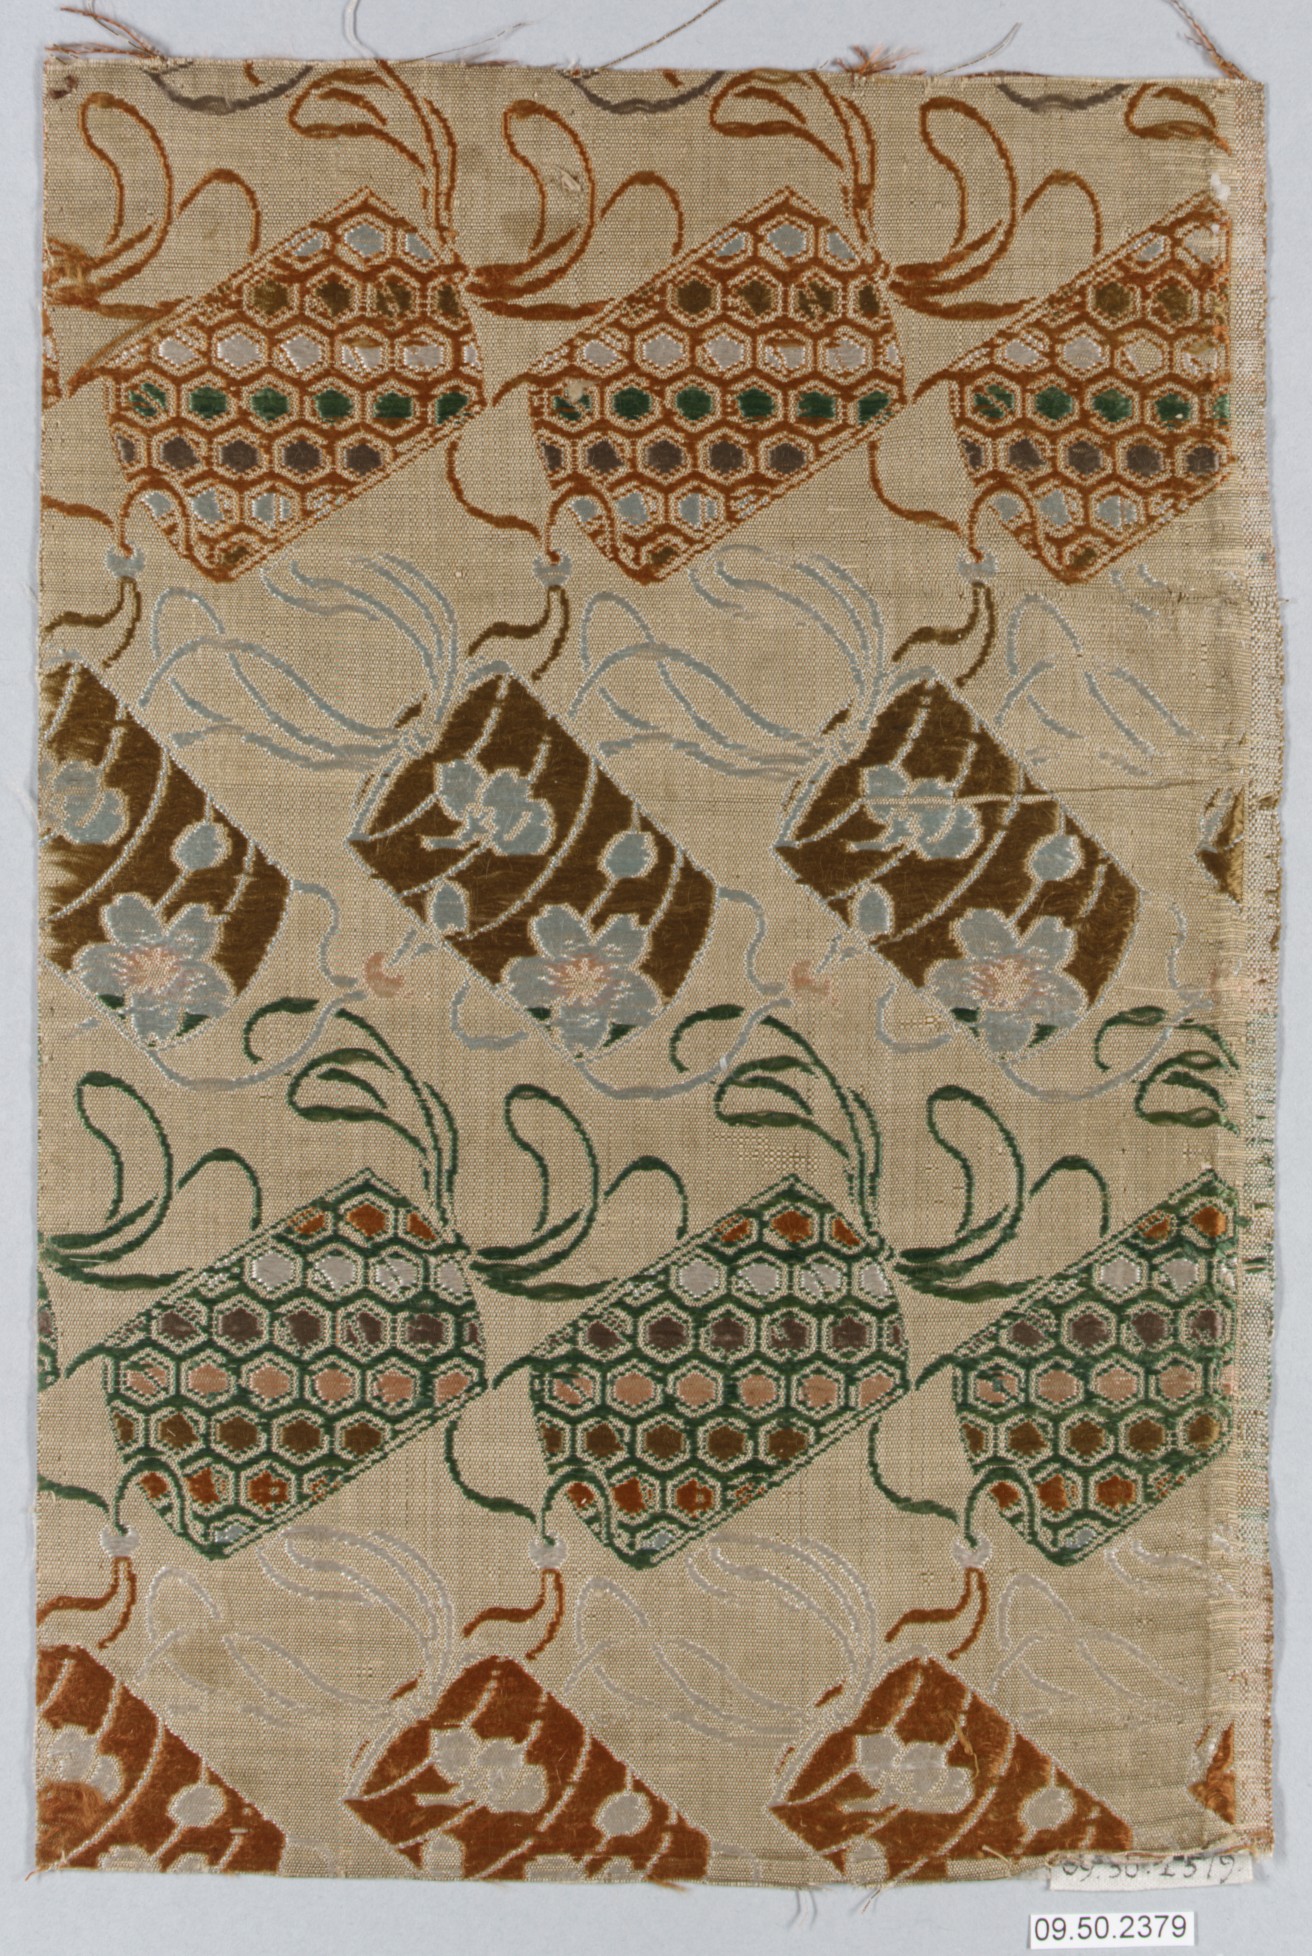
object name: piece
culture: japanese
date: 1801-1900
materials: silk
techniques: brocade